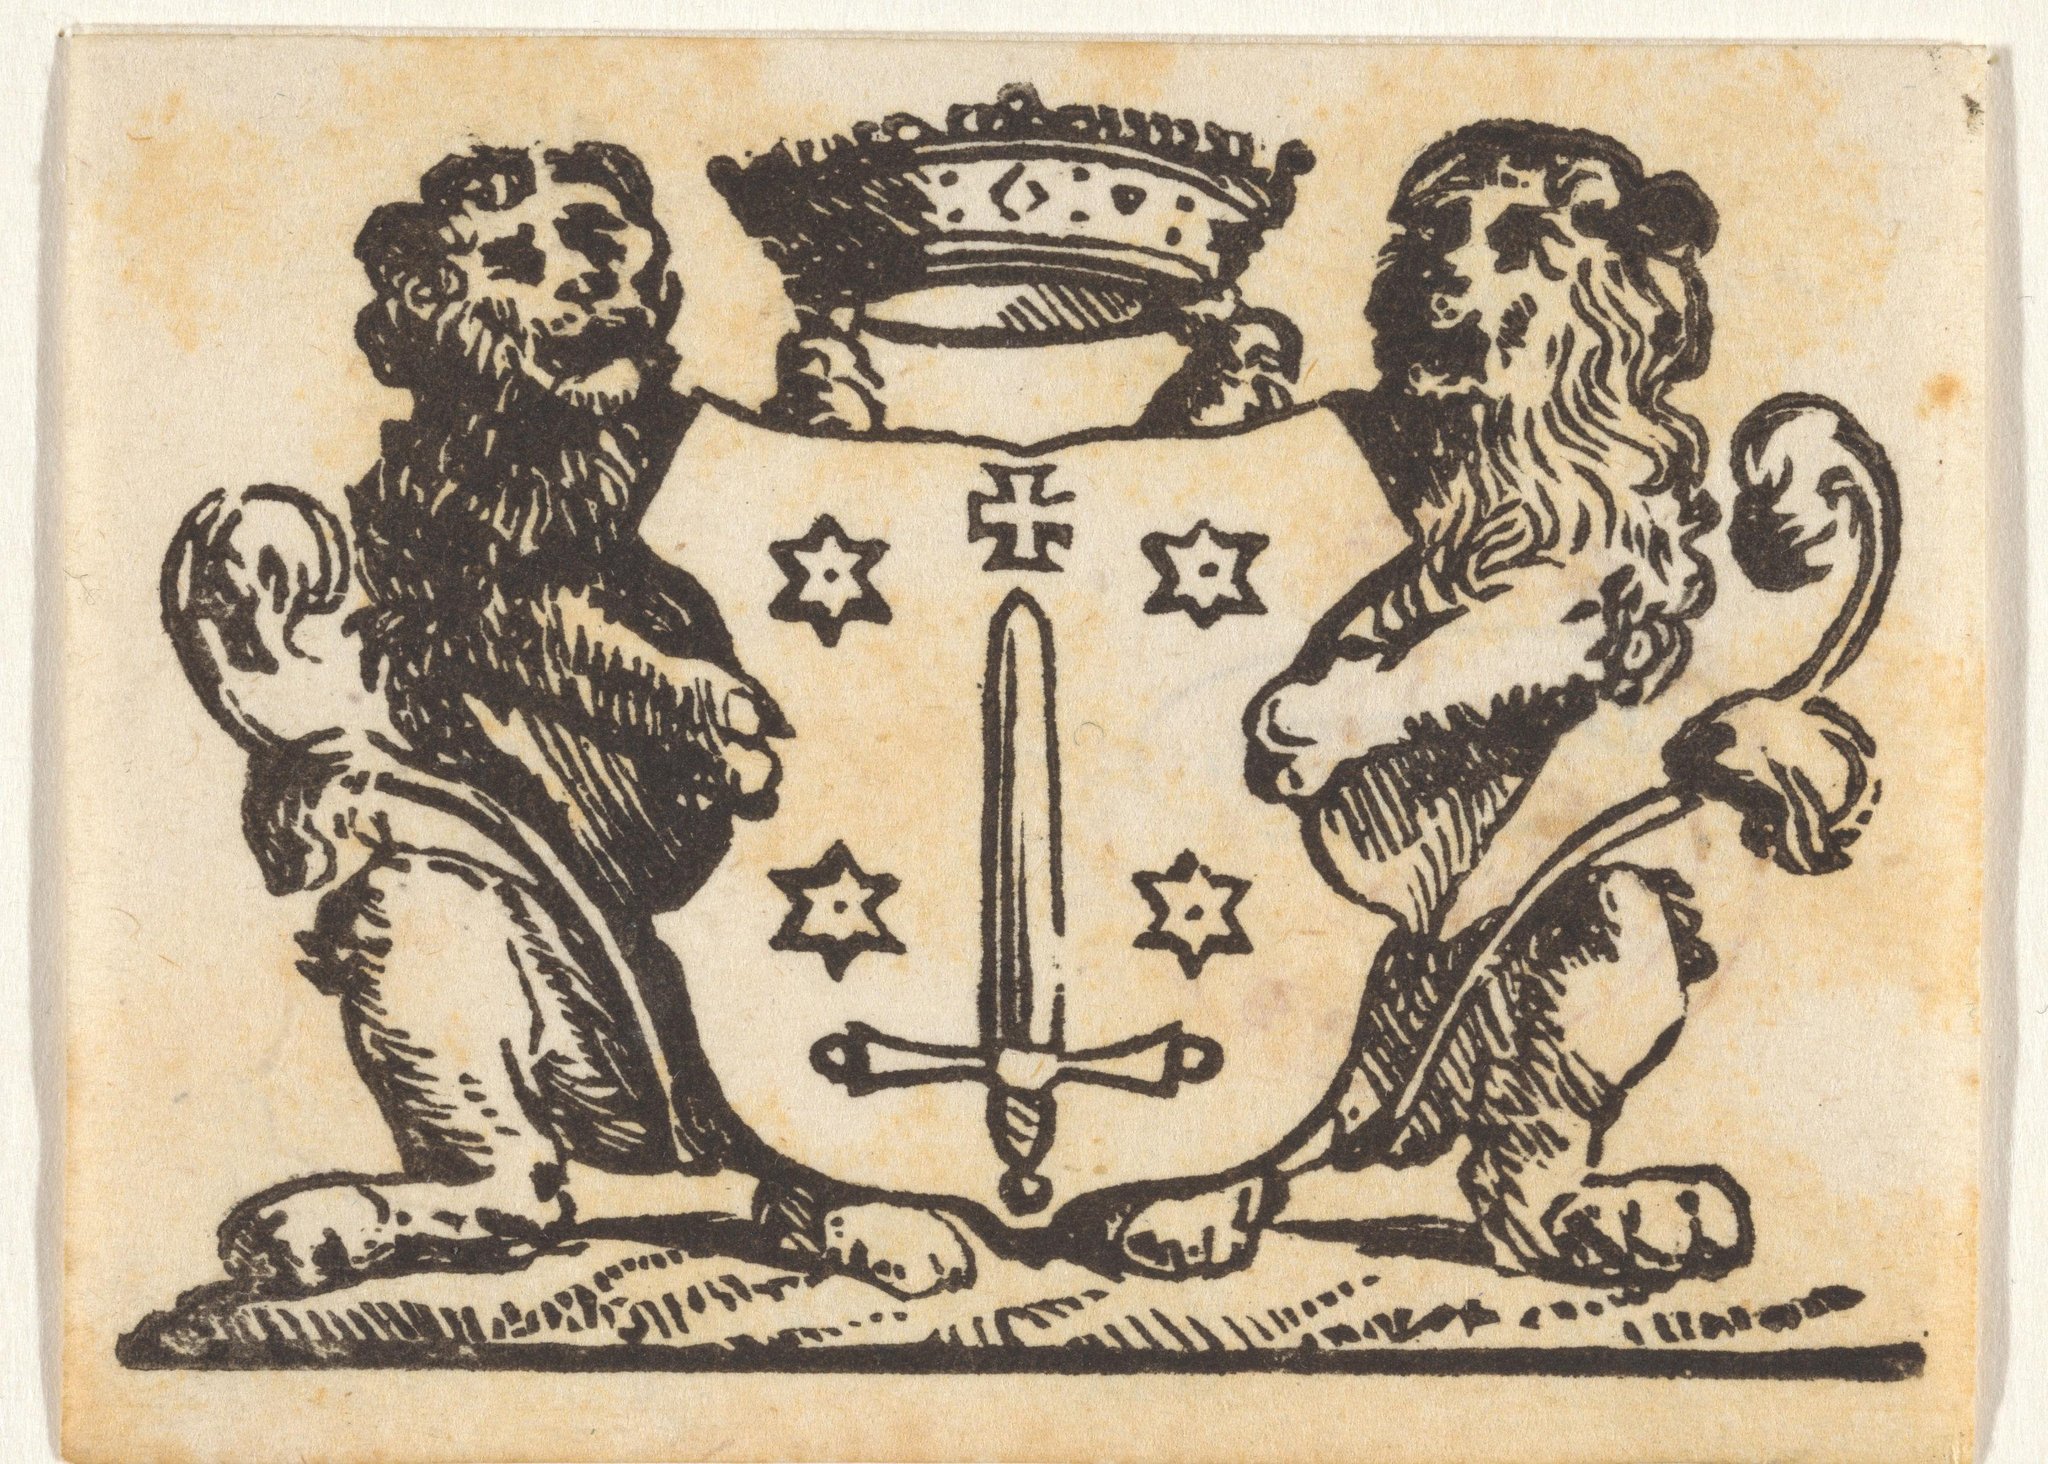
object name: print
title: Vignet met het wapen van de stad Haarlem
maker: Anonymous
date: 1600-1699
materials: paper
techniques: woodcut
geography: netherlands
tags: coat of arms (as symbol of the state, etc.) (+ city; municipal), vignette, haarlem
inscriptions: collector's mark: Lugt 240, collector's mark: Lugt 698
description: Het wapen van de stad Haarlem met een kroon en twee leeuwen.